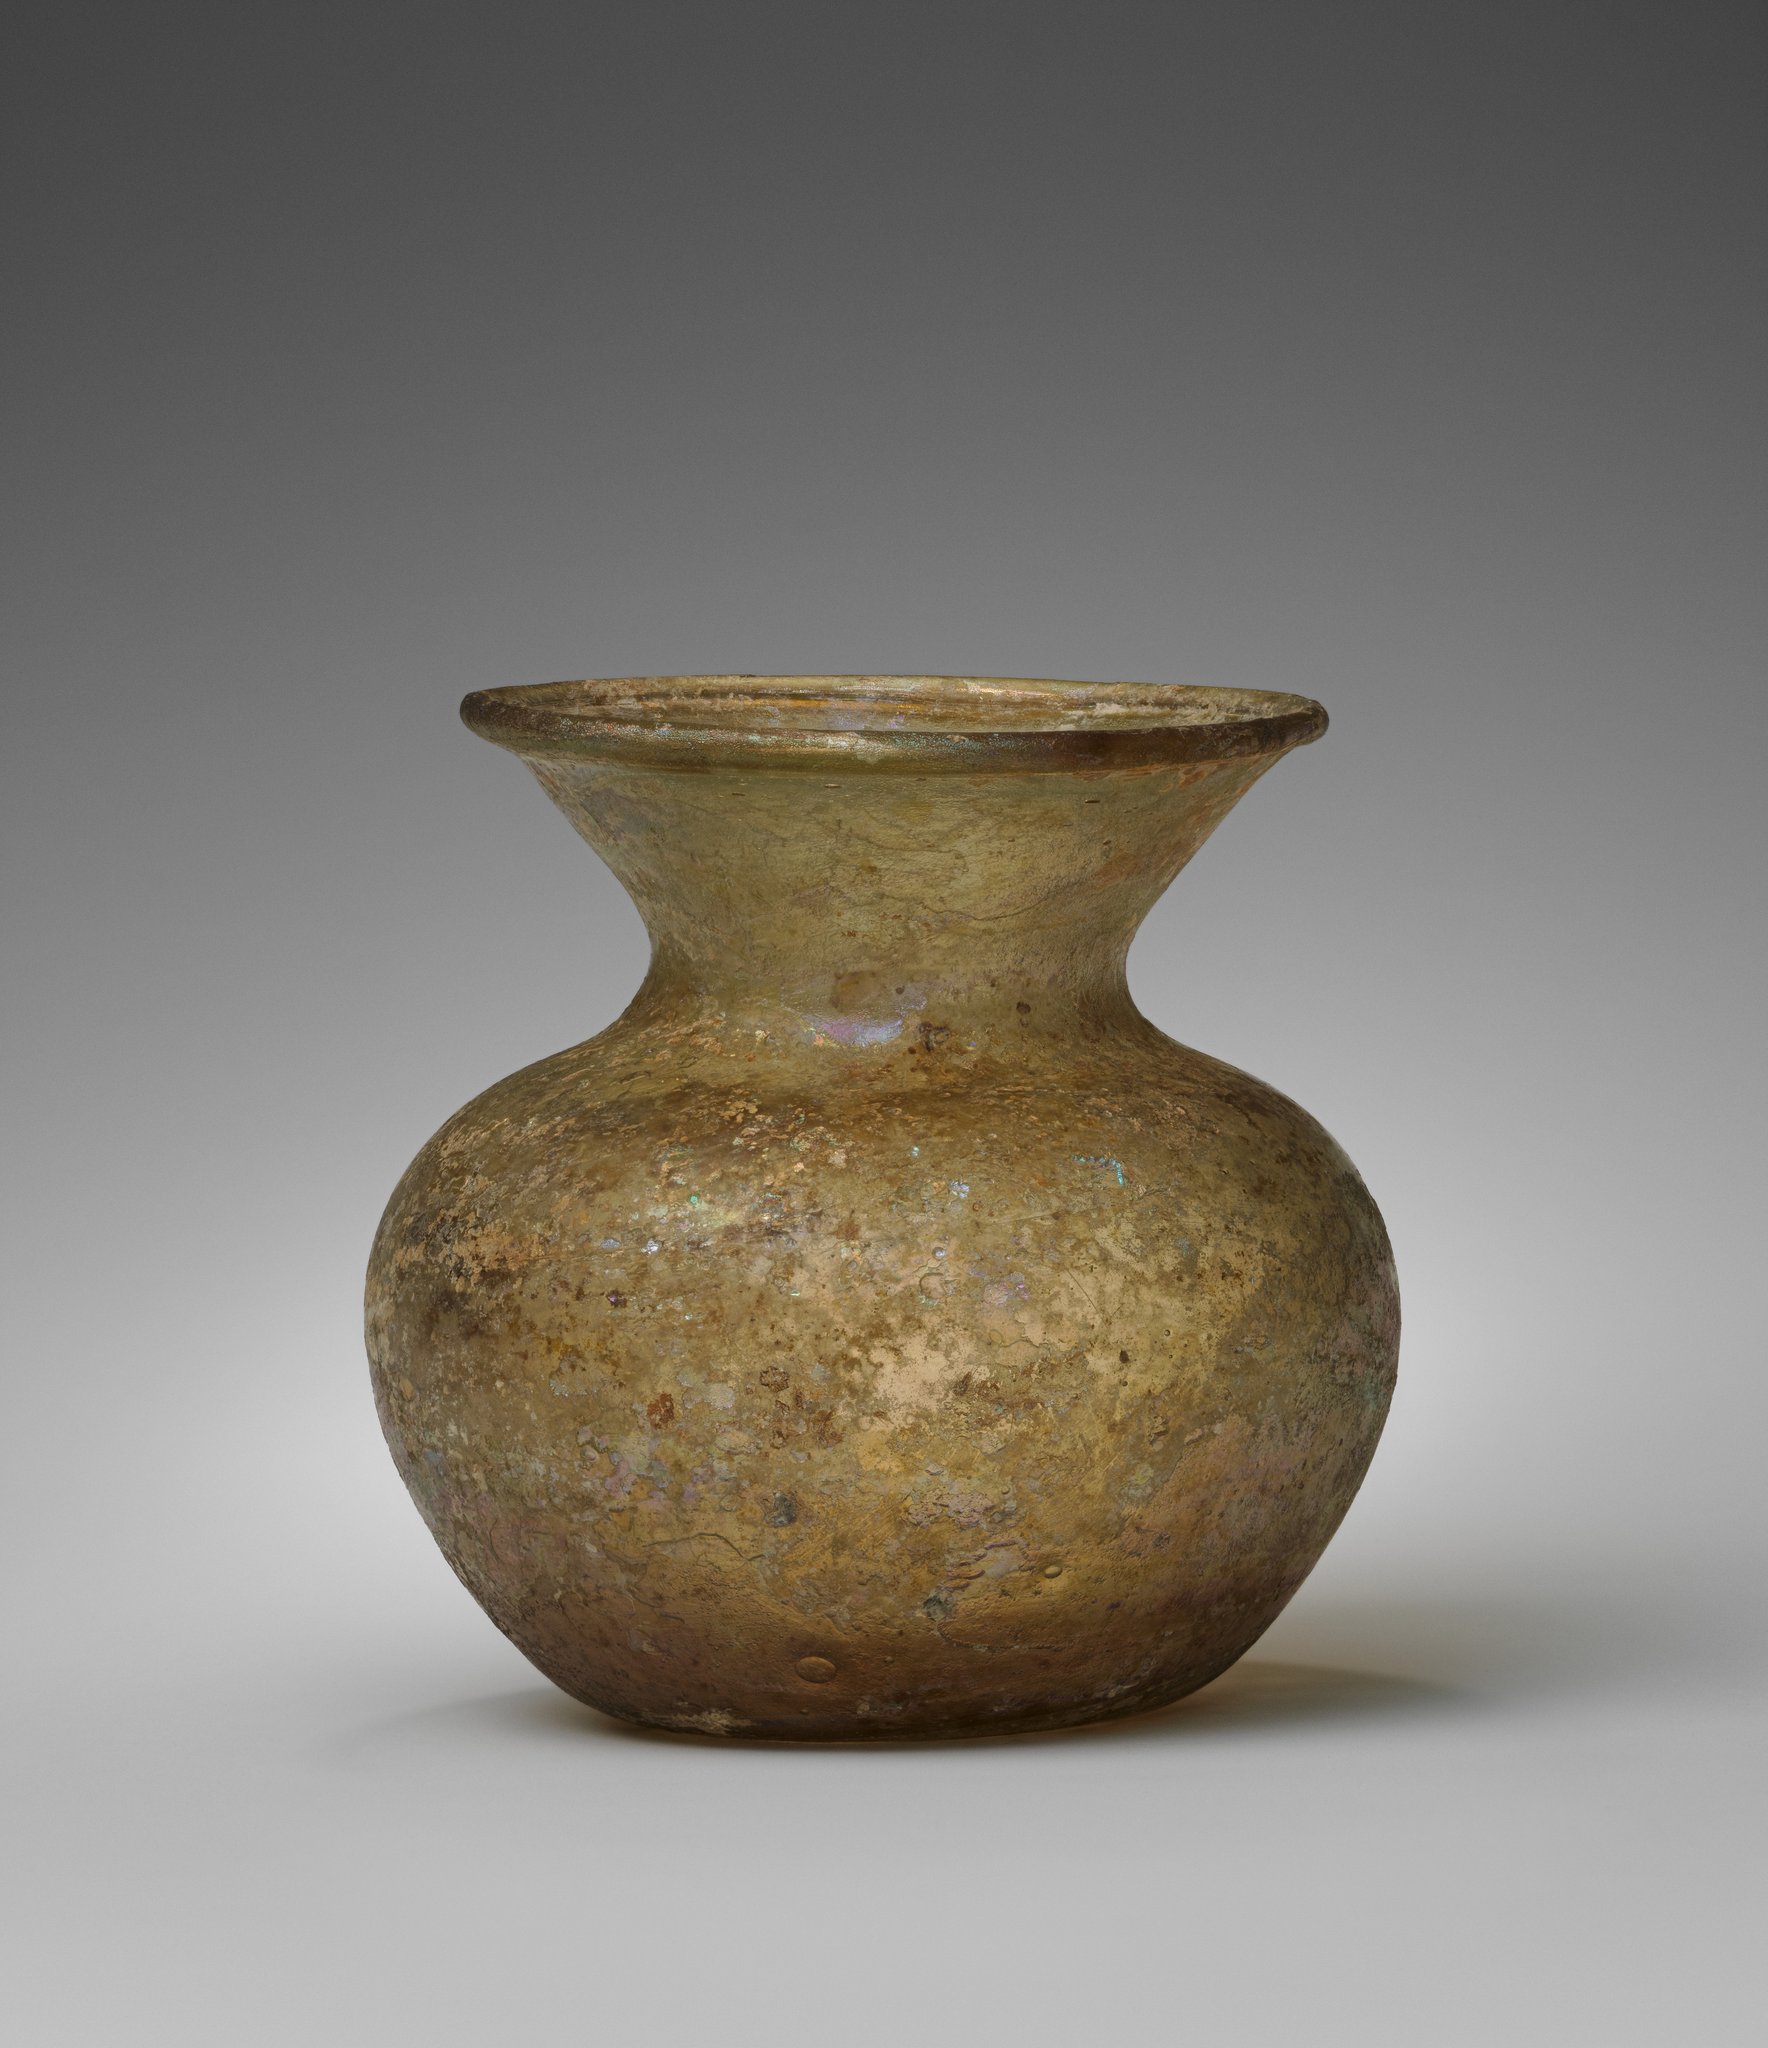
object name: jar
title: Glass jar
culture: roman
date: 201-300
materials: glass